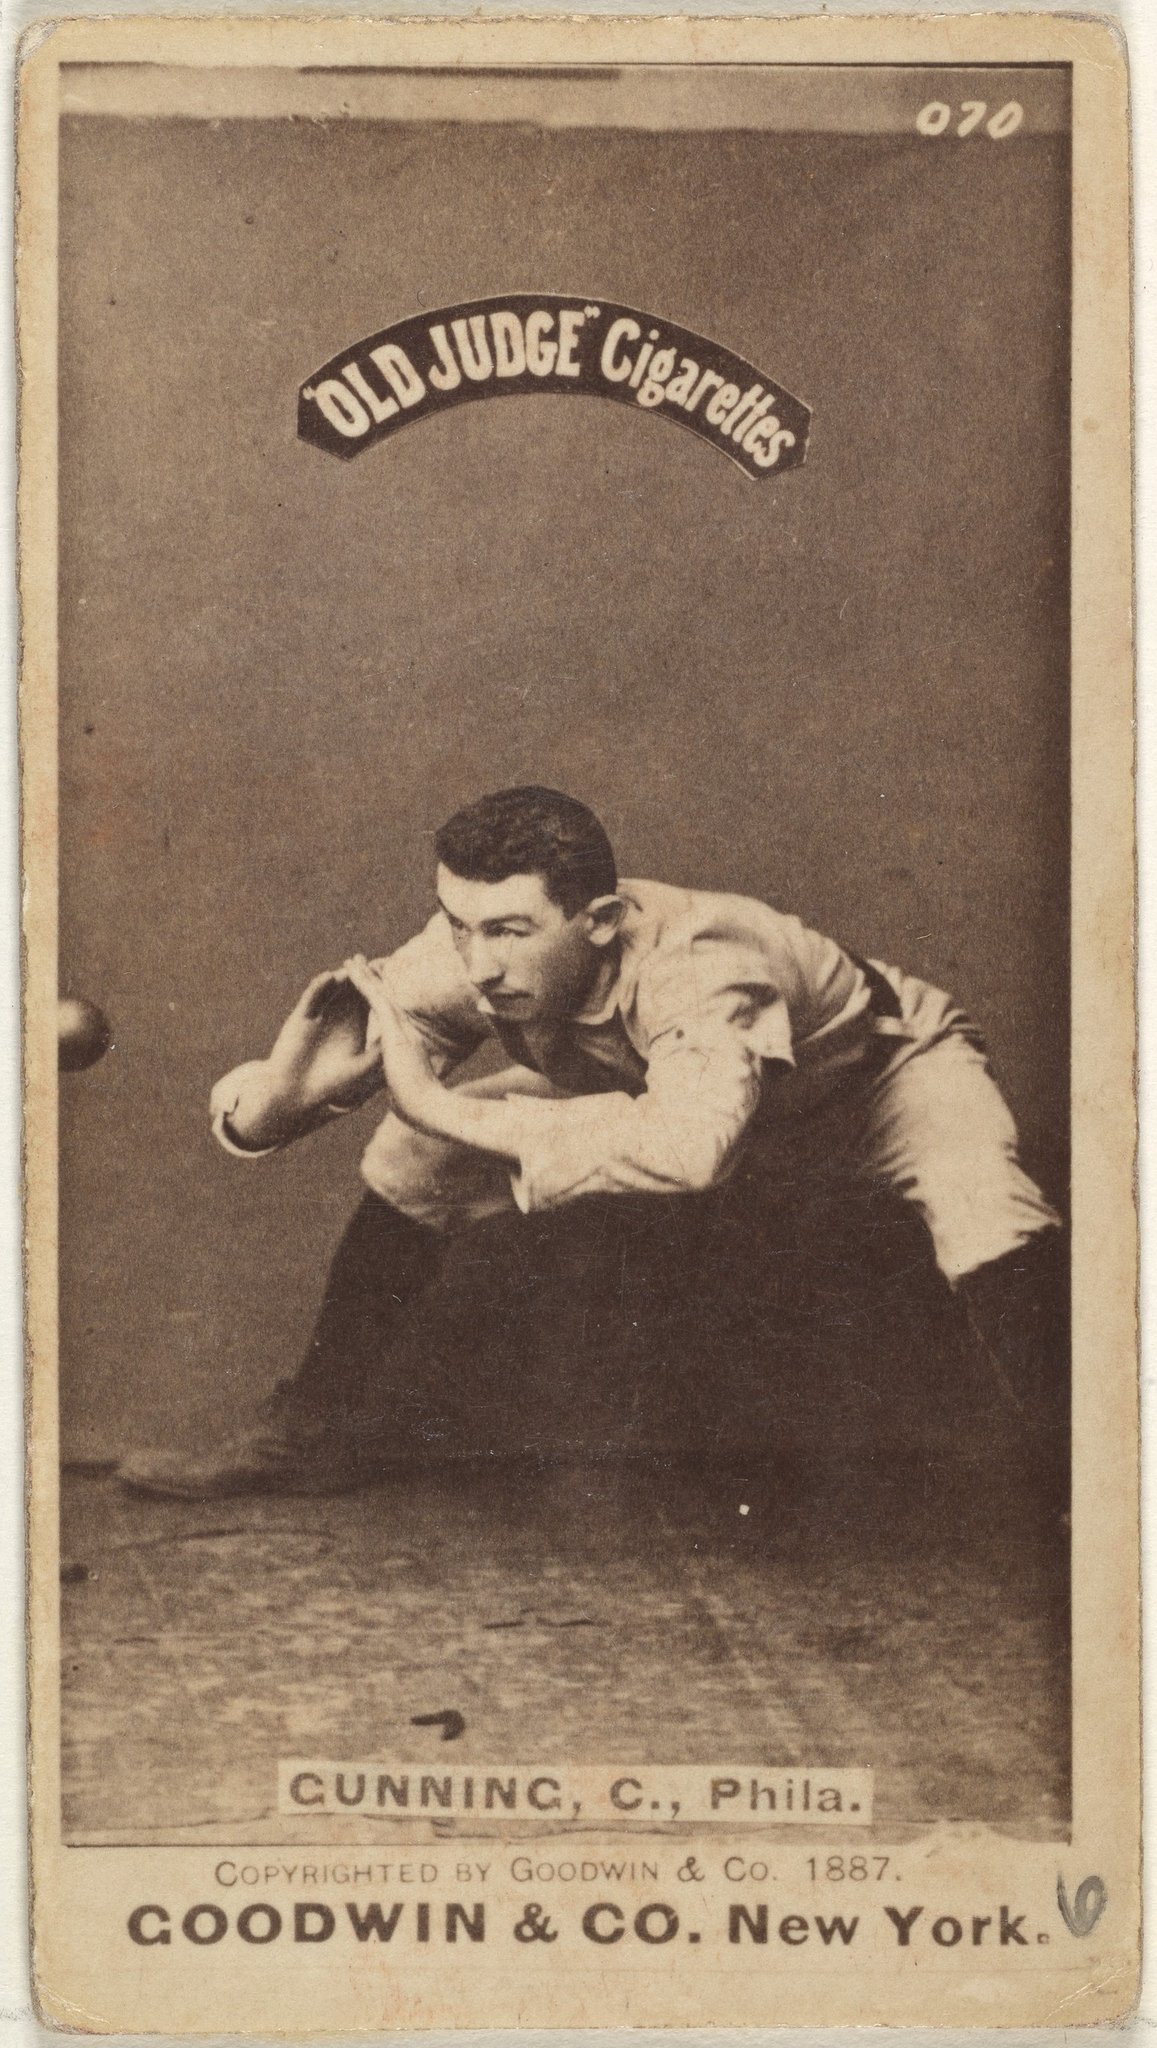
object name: baseball card, photograph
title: Thomas Francis Gunning, Catcher, Philadelphia, from the Old Judge series (N172) for Old Judge Cigarettes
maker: goodwin & company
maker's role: publisher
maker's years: 1850-1950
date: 1887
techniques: albumen silver print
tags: men,portraits,baseball,athletes